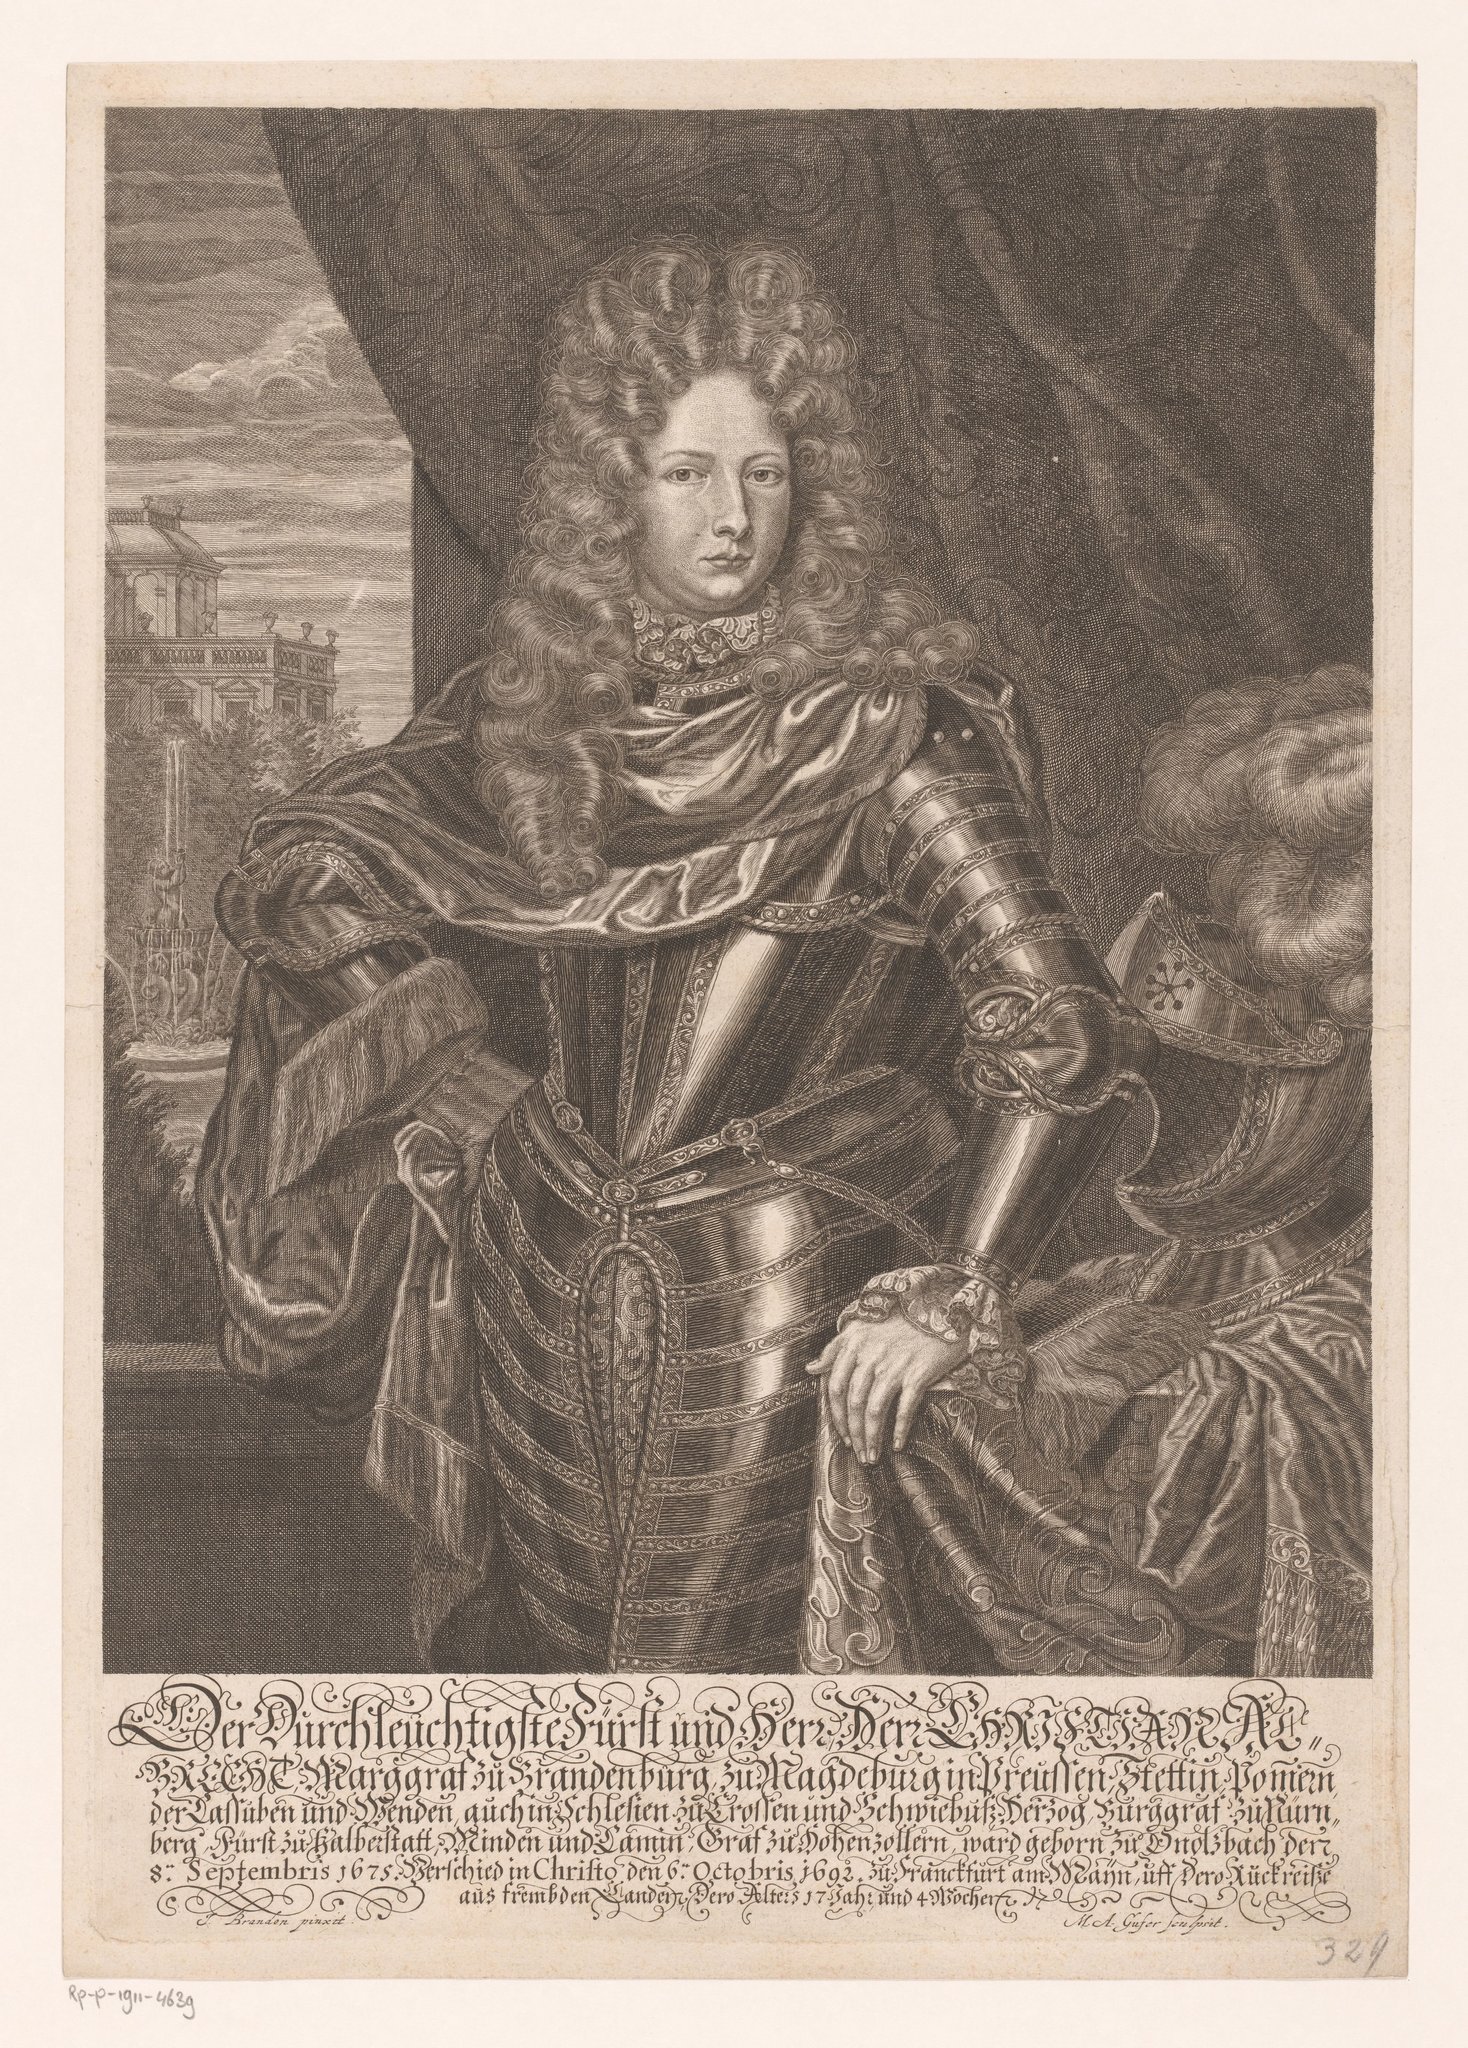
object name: print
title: Portret van Christian Albrecht von Brandenburg-Ansbach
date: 1692-1695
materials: paper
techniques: engraving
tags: earl, helmet, city-view, and landscape with man-made constructions, armour, historical persons, ruler, sovereign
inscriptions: collector's mark: Lugt 2228